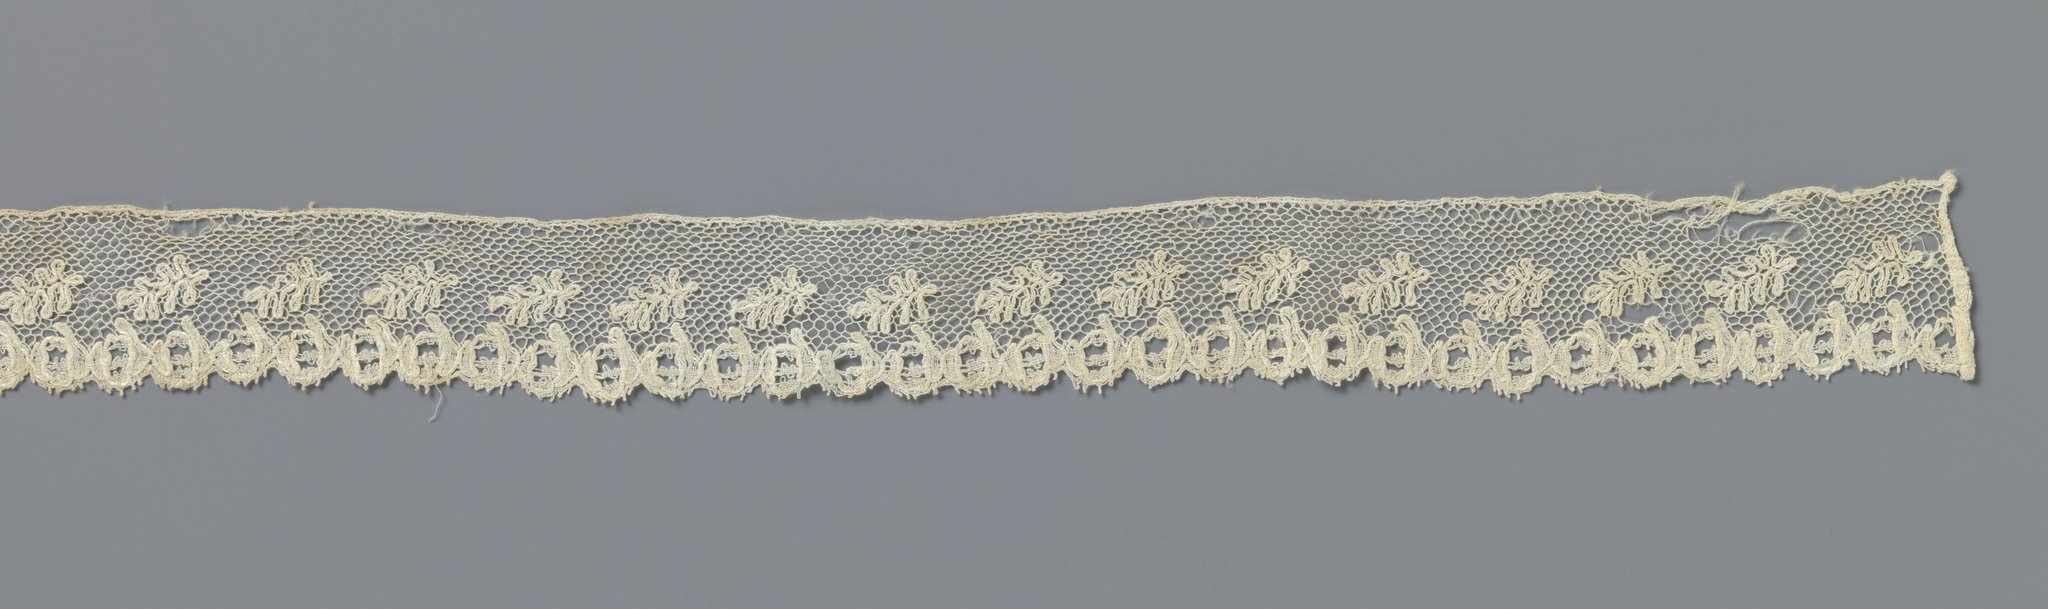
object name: strip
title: Strook kloskant met schuin geplaatste veervormige blaadjes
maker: Anonymous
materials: linen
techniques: lace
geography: lille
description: Strook naturelkleurige kloskant: Rijselse kant. Het zich herhalende patroon bestaat op de middenlijn uit een rij schuin geplaatste veervormige blaadjes met daaronder een rij aaneengeschakelde cirkelvormige motiefjes, die opengewerkte schulpjes vormen. De motieven zijn met elkaar verbonden door een fijne traliegrond, een tulegrond. Het spaarzame volwerk is gemaakt in linnenslag, met dikkere en glimmende contourdraden. De bovenzijde is recht afgewerkt. De schulpjes langs de onderzijde zijn afgewerkt met picots.